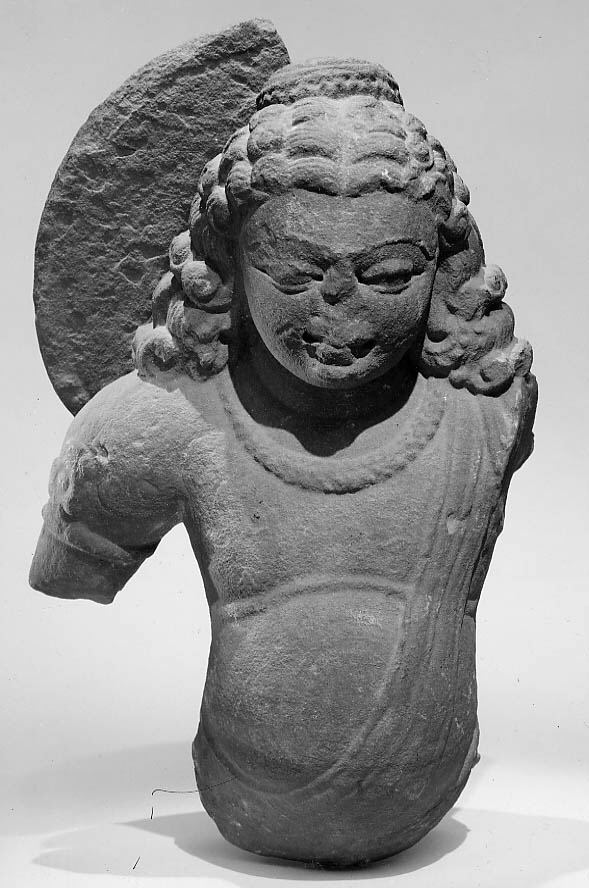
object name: figure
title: Kubera (Dhanada)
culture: indian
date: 501-600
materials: stone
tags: post-gupta,hinduism